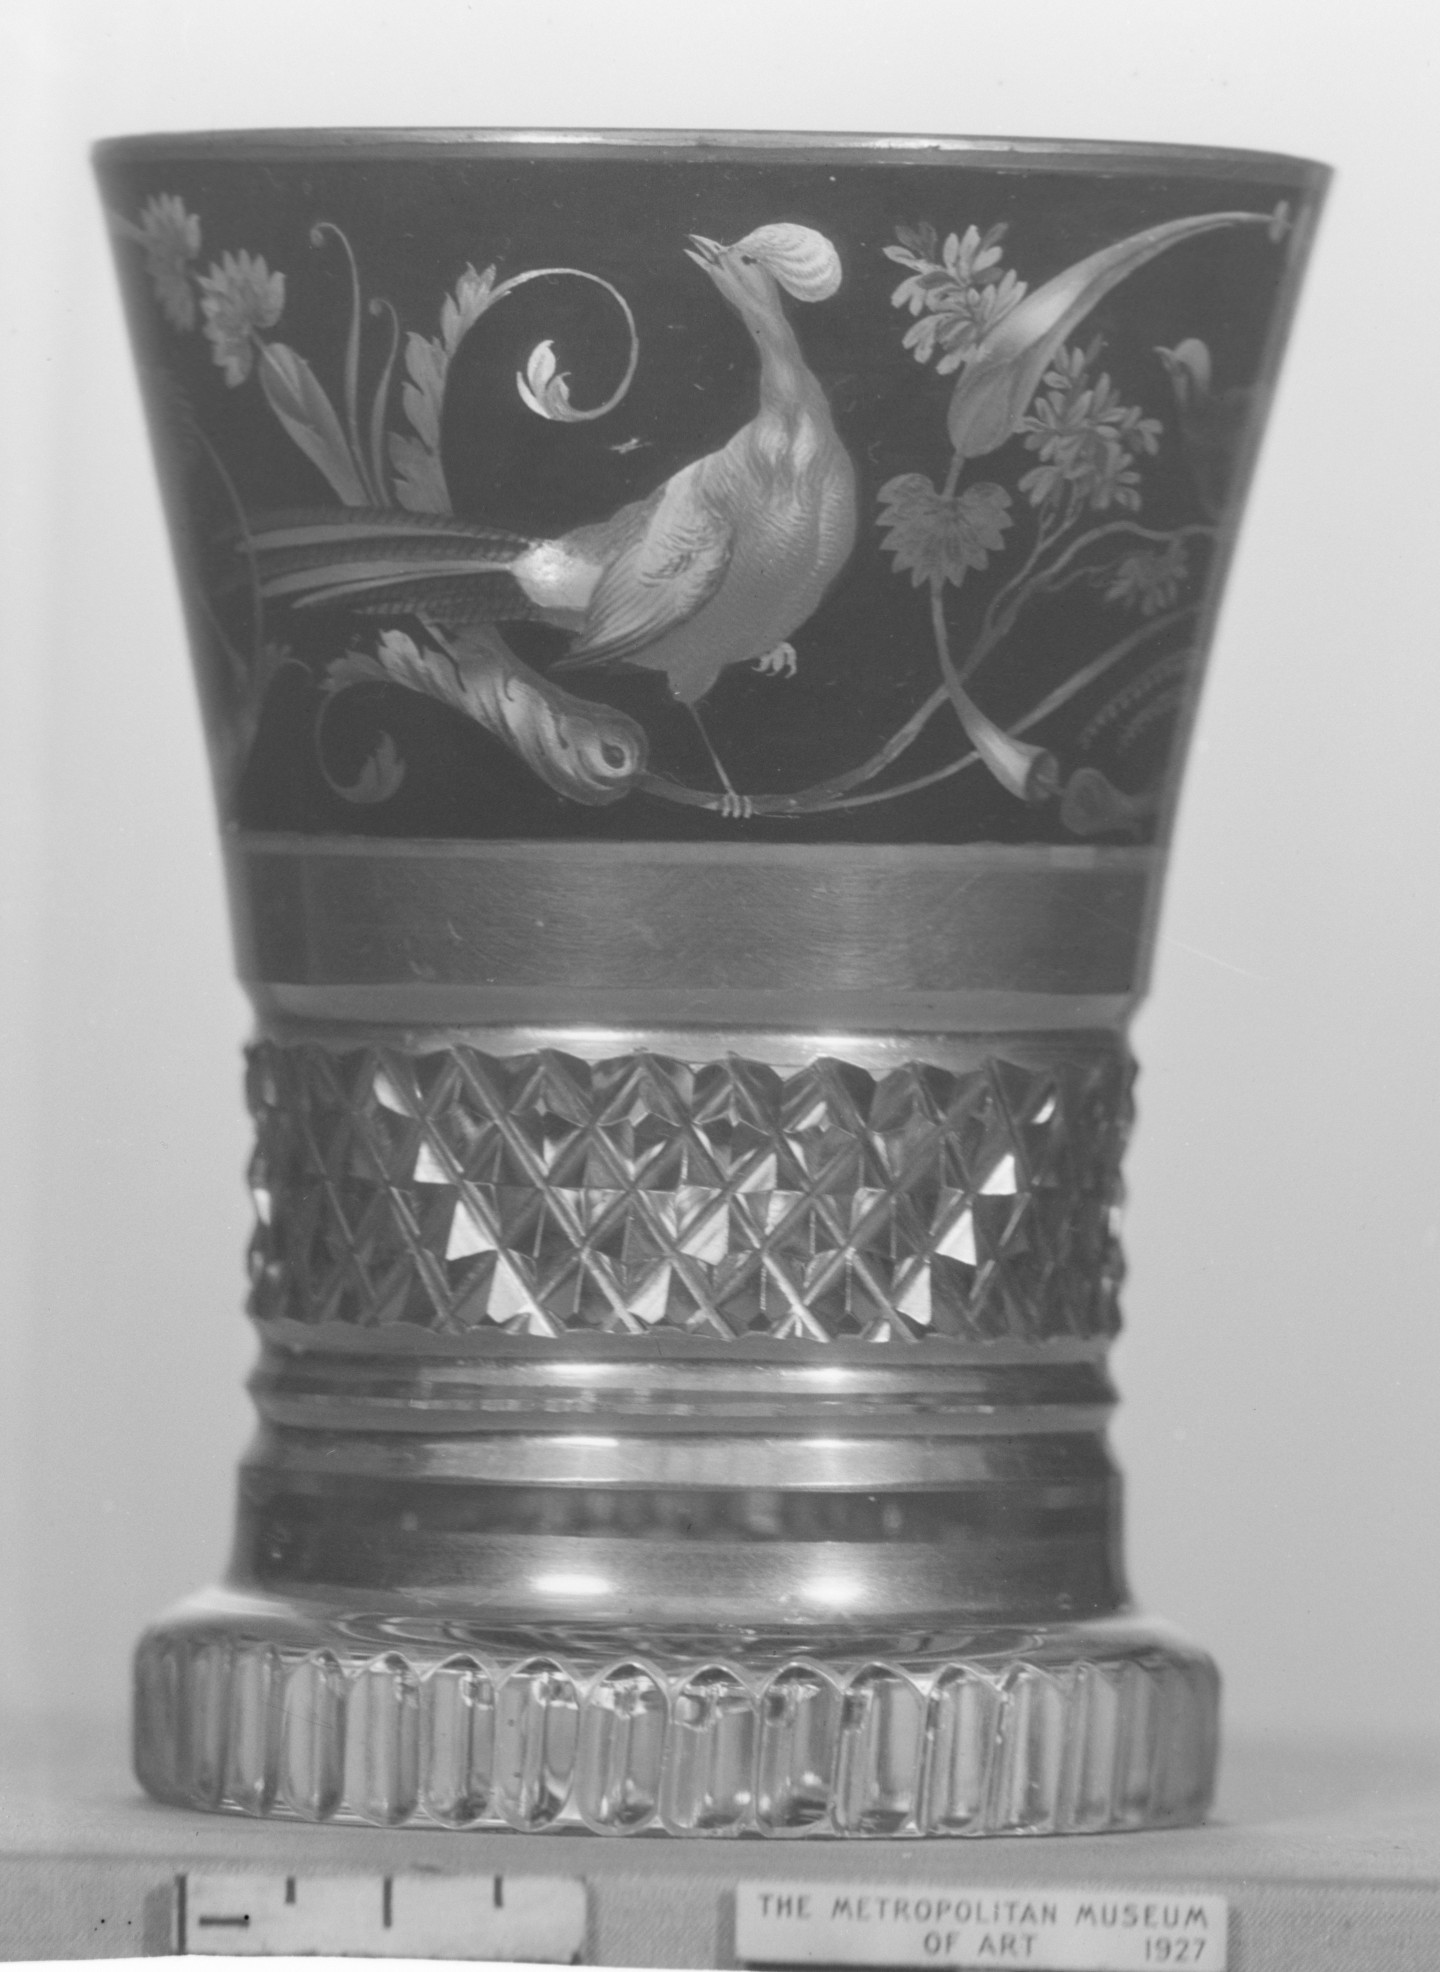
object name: beaker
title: Beaker (Ranftbecher)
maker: anton kothgasser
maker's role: decorator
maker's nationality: austrian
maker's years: 1769-1851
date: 1830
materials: gilt, glass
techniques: cutting, enamel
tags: birds